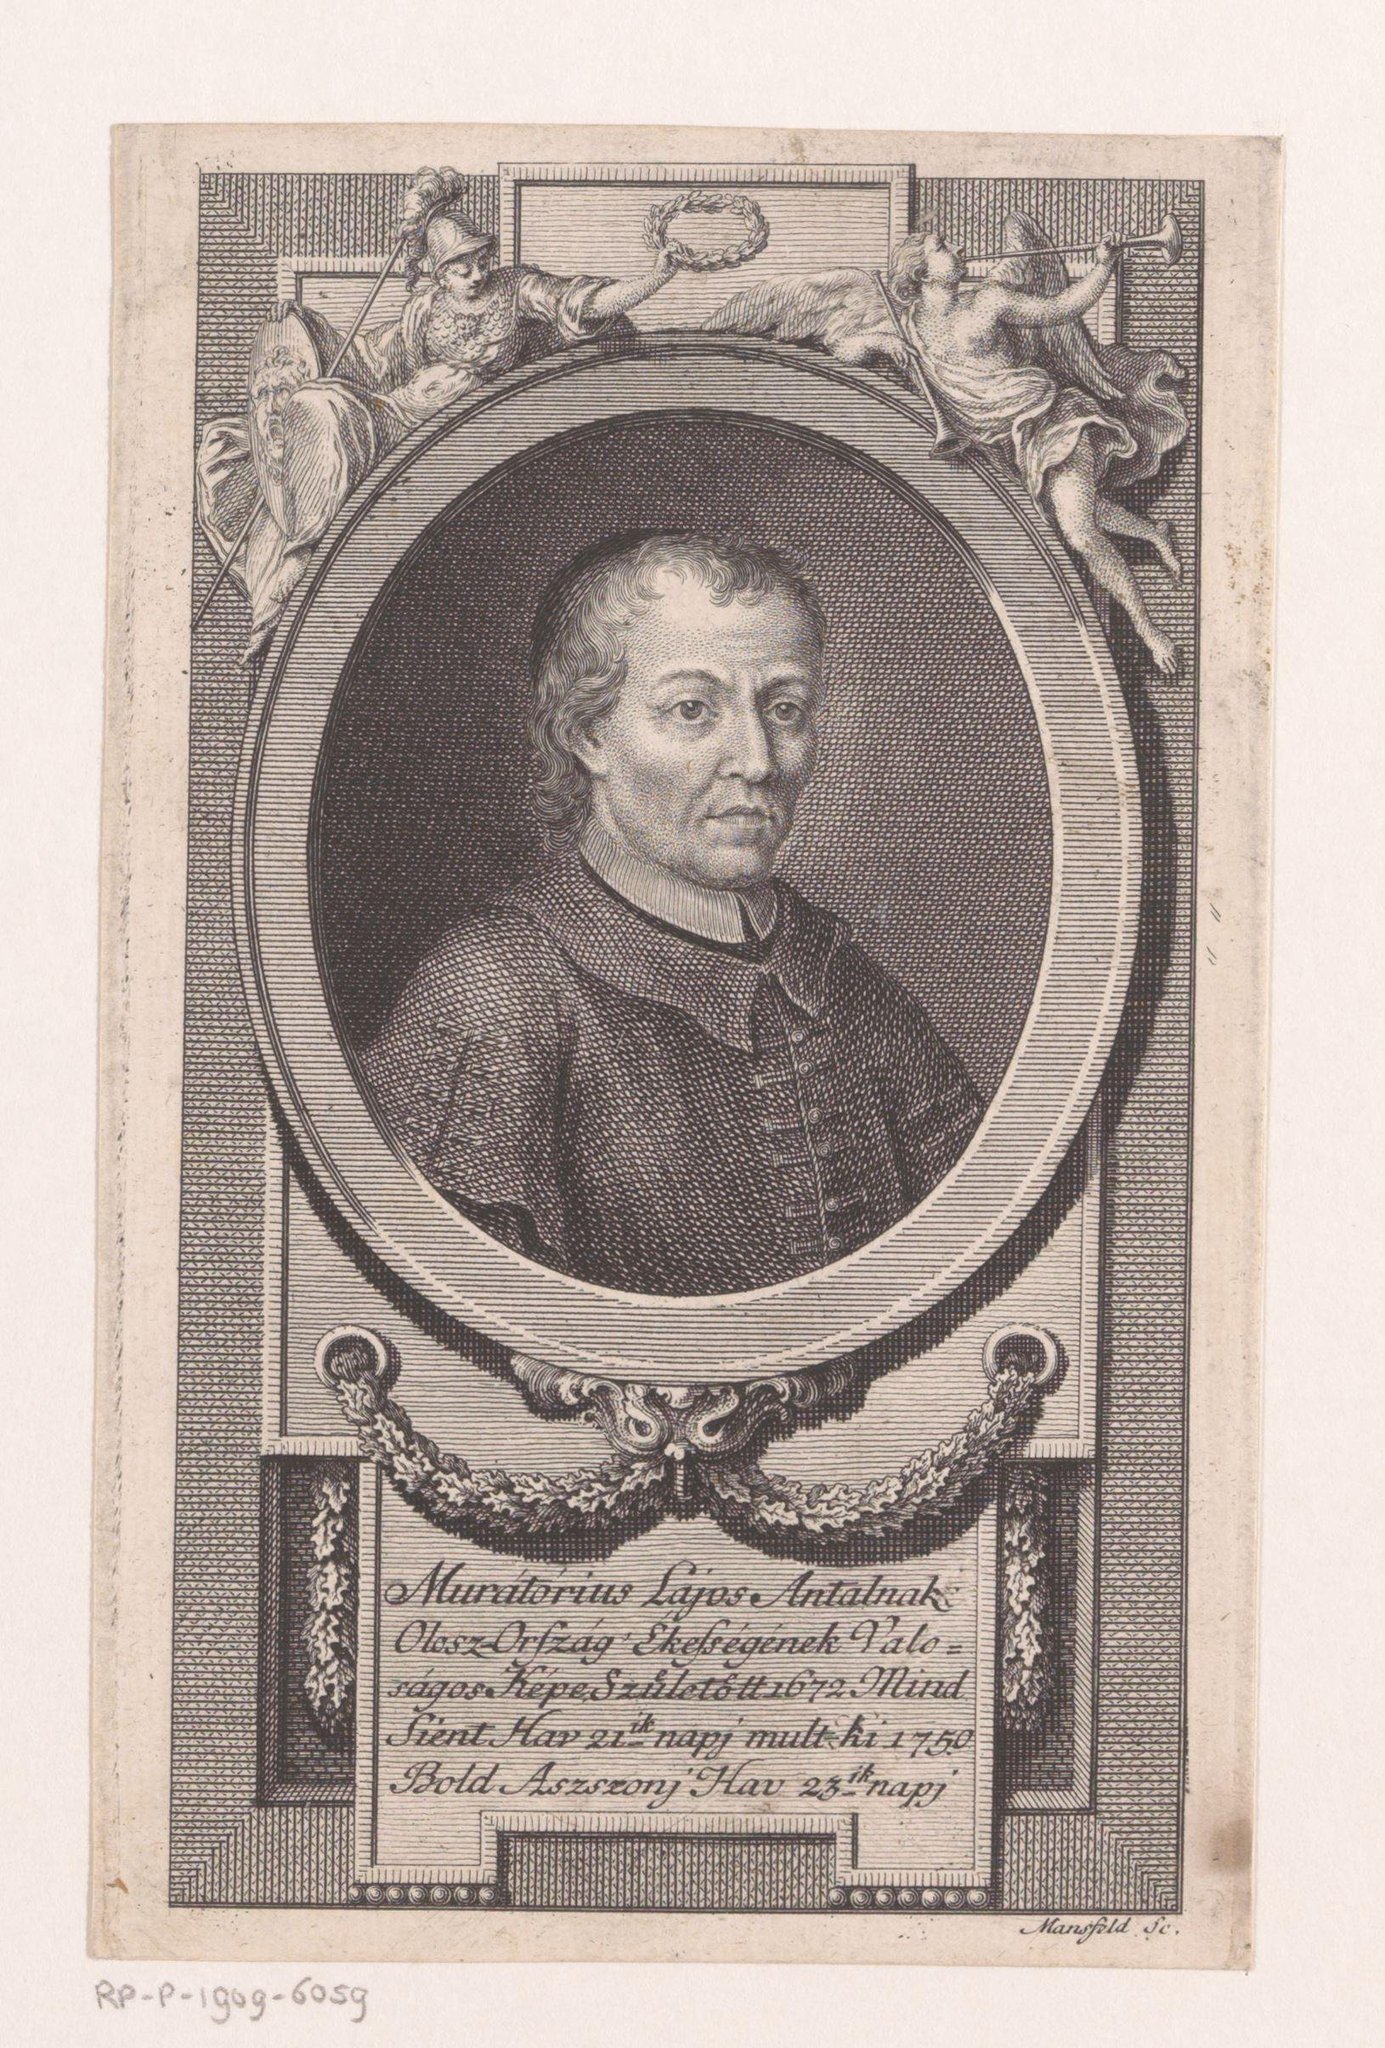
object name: print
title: Portret van Lodovico Antonio Muratori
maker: johann ernst mansfeld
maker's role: print maker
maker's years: 1739-1796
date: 1750-1796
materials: paper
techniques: engraving, etching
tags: (story of) minerva (pallas, athena), wisdom; 'sapienza', 'sapienza humana', 'sapienza vera' (ripa), historical persons, fame; 'fama', 'fama buona', 'fama chiara' (ripa)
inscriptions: collector's mark: Lugt 2228